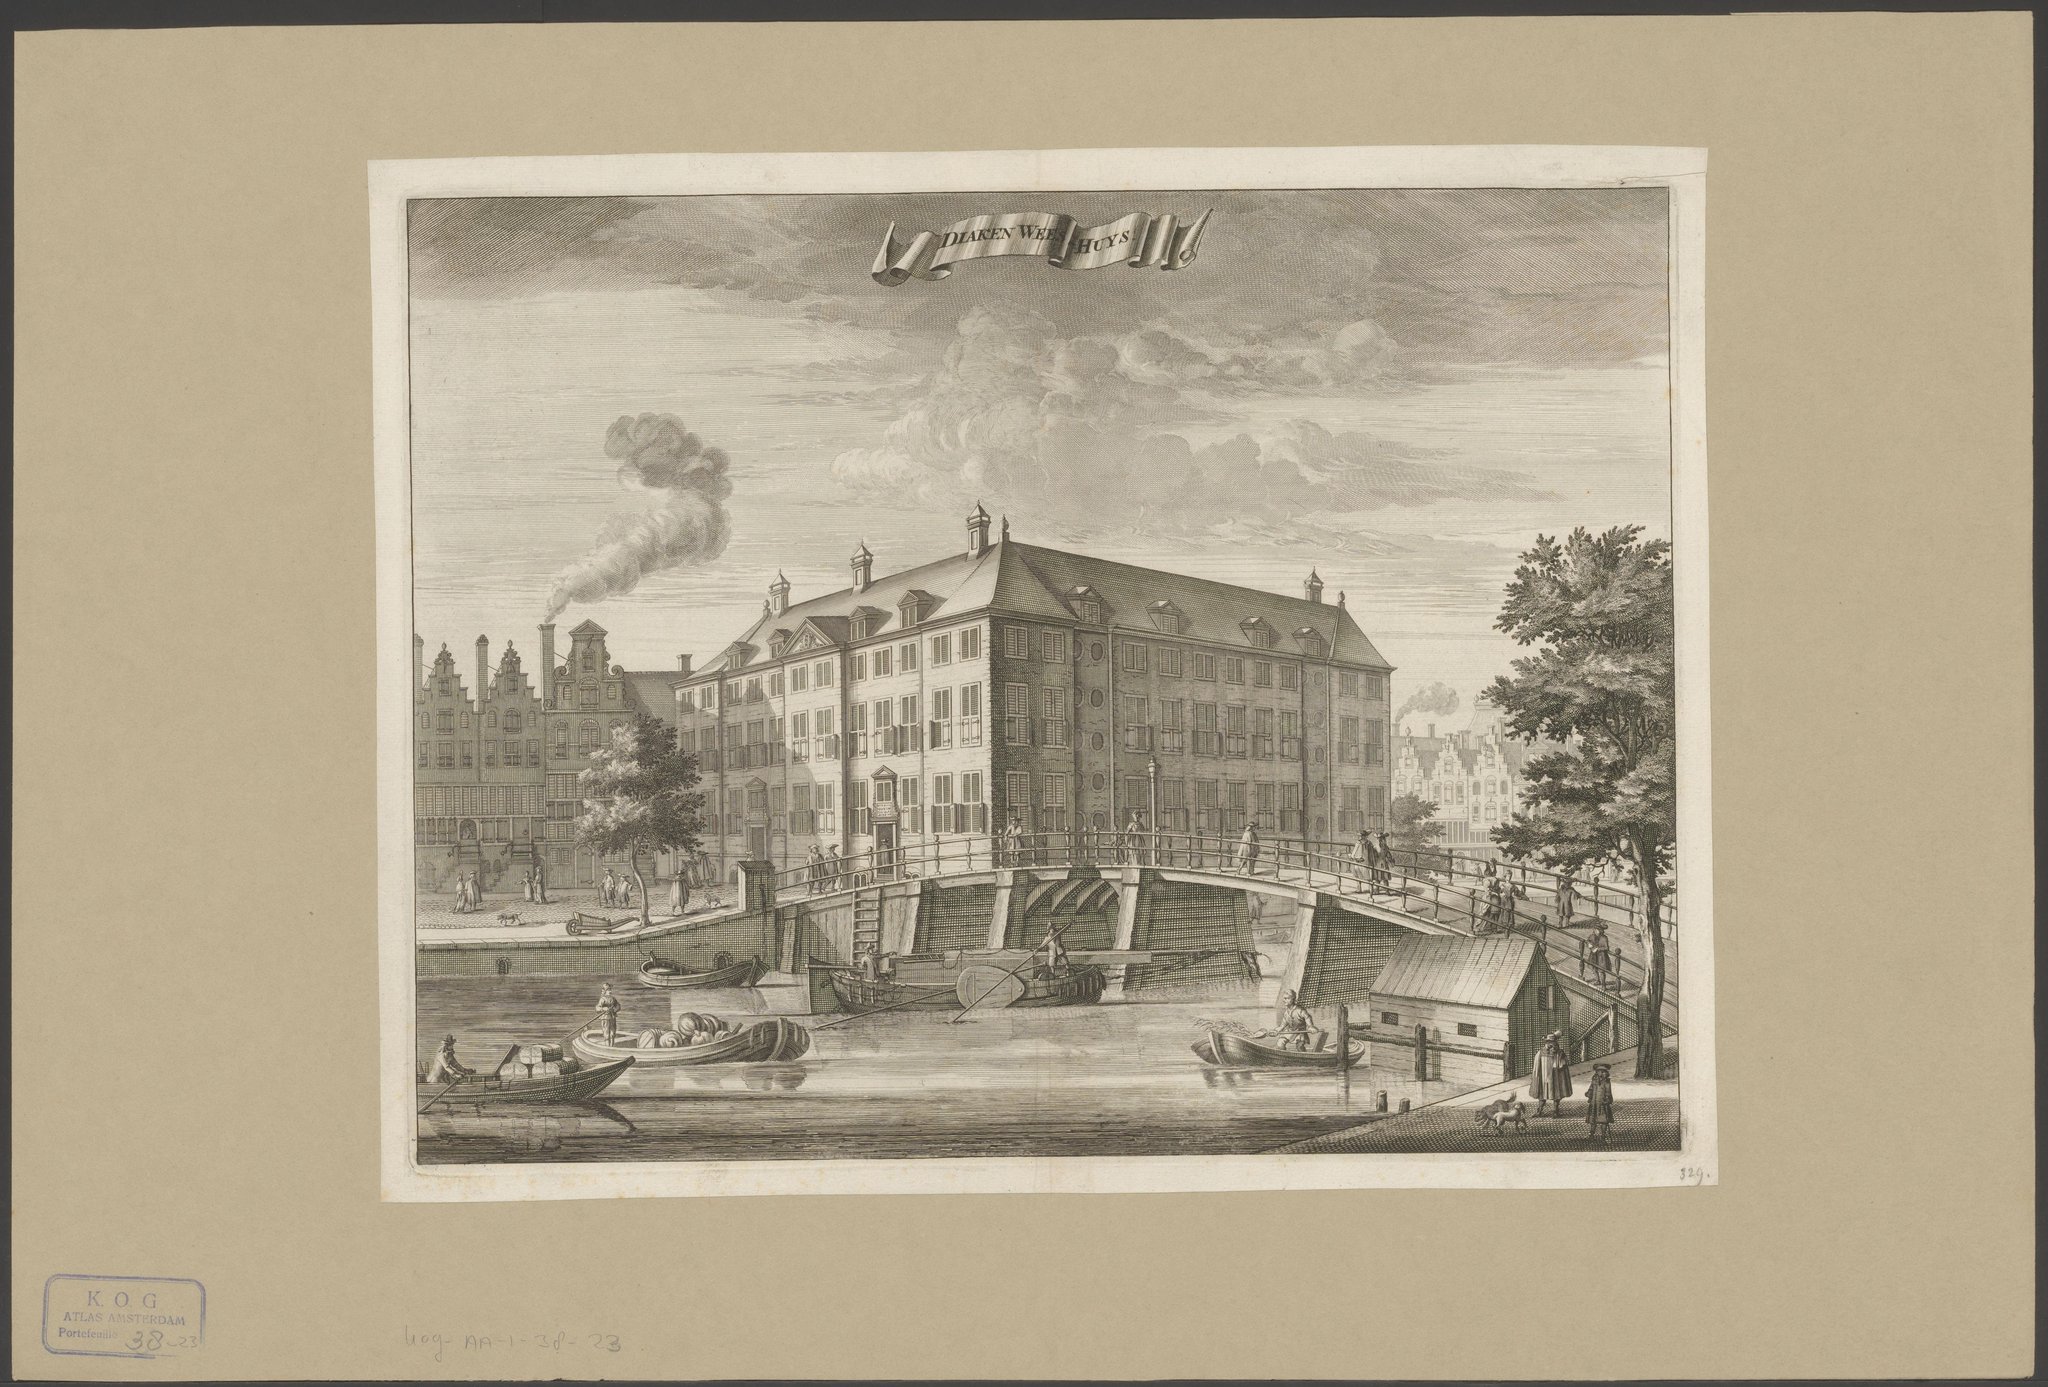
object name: print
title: Gezicht op het Diaconieweeshuis te Amsterdam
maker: Anonymous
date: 1726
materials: paper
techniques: engraving, etching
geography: northern netherlands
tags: bridge in city across river, canal, etc. (+ city(-scape) with figures, staffage), rowing-boat, canoe, etc., orphanage, canals, waters (in city) (+ city(-scape) with figures, staffage)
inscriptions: collector's mark: Lugt 1641b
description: Huidige staat van prent ook gebruikt in: Commelin, Casparus. Beschryvinge van Amsterdam (…). 2de druk. Amsterdam: Andries van Damme, Johannes Ratelband, weduwe Antony van Aeltwijk en Hermanus Uytwerf, 1726, dl. 2. Eerste staat van prent (zonder opgewerkte lucht- en waterpartijen) ook gebruikt in: Commelin, Casparus. Beschryvinge van Amsterdam (…). Amsterdam: Abraham Wolfgang, Gillis Janssonius van Waesberge of Johannes Janssonius van Waesberge, Hendrick Boom of weduwe Dirk Boom, Abraham van Sanderen en Rembertus Goethals, 1693, dl. 2. En in: Commelin, Casparus. Beschryvinge van Amsterdam (…). Amsterdam: weduwe Aart Dircksz. Oossaan, 1694, dl. 2.